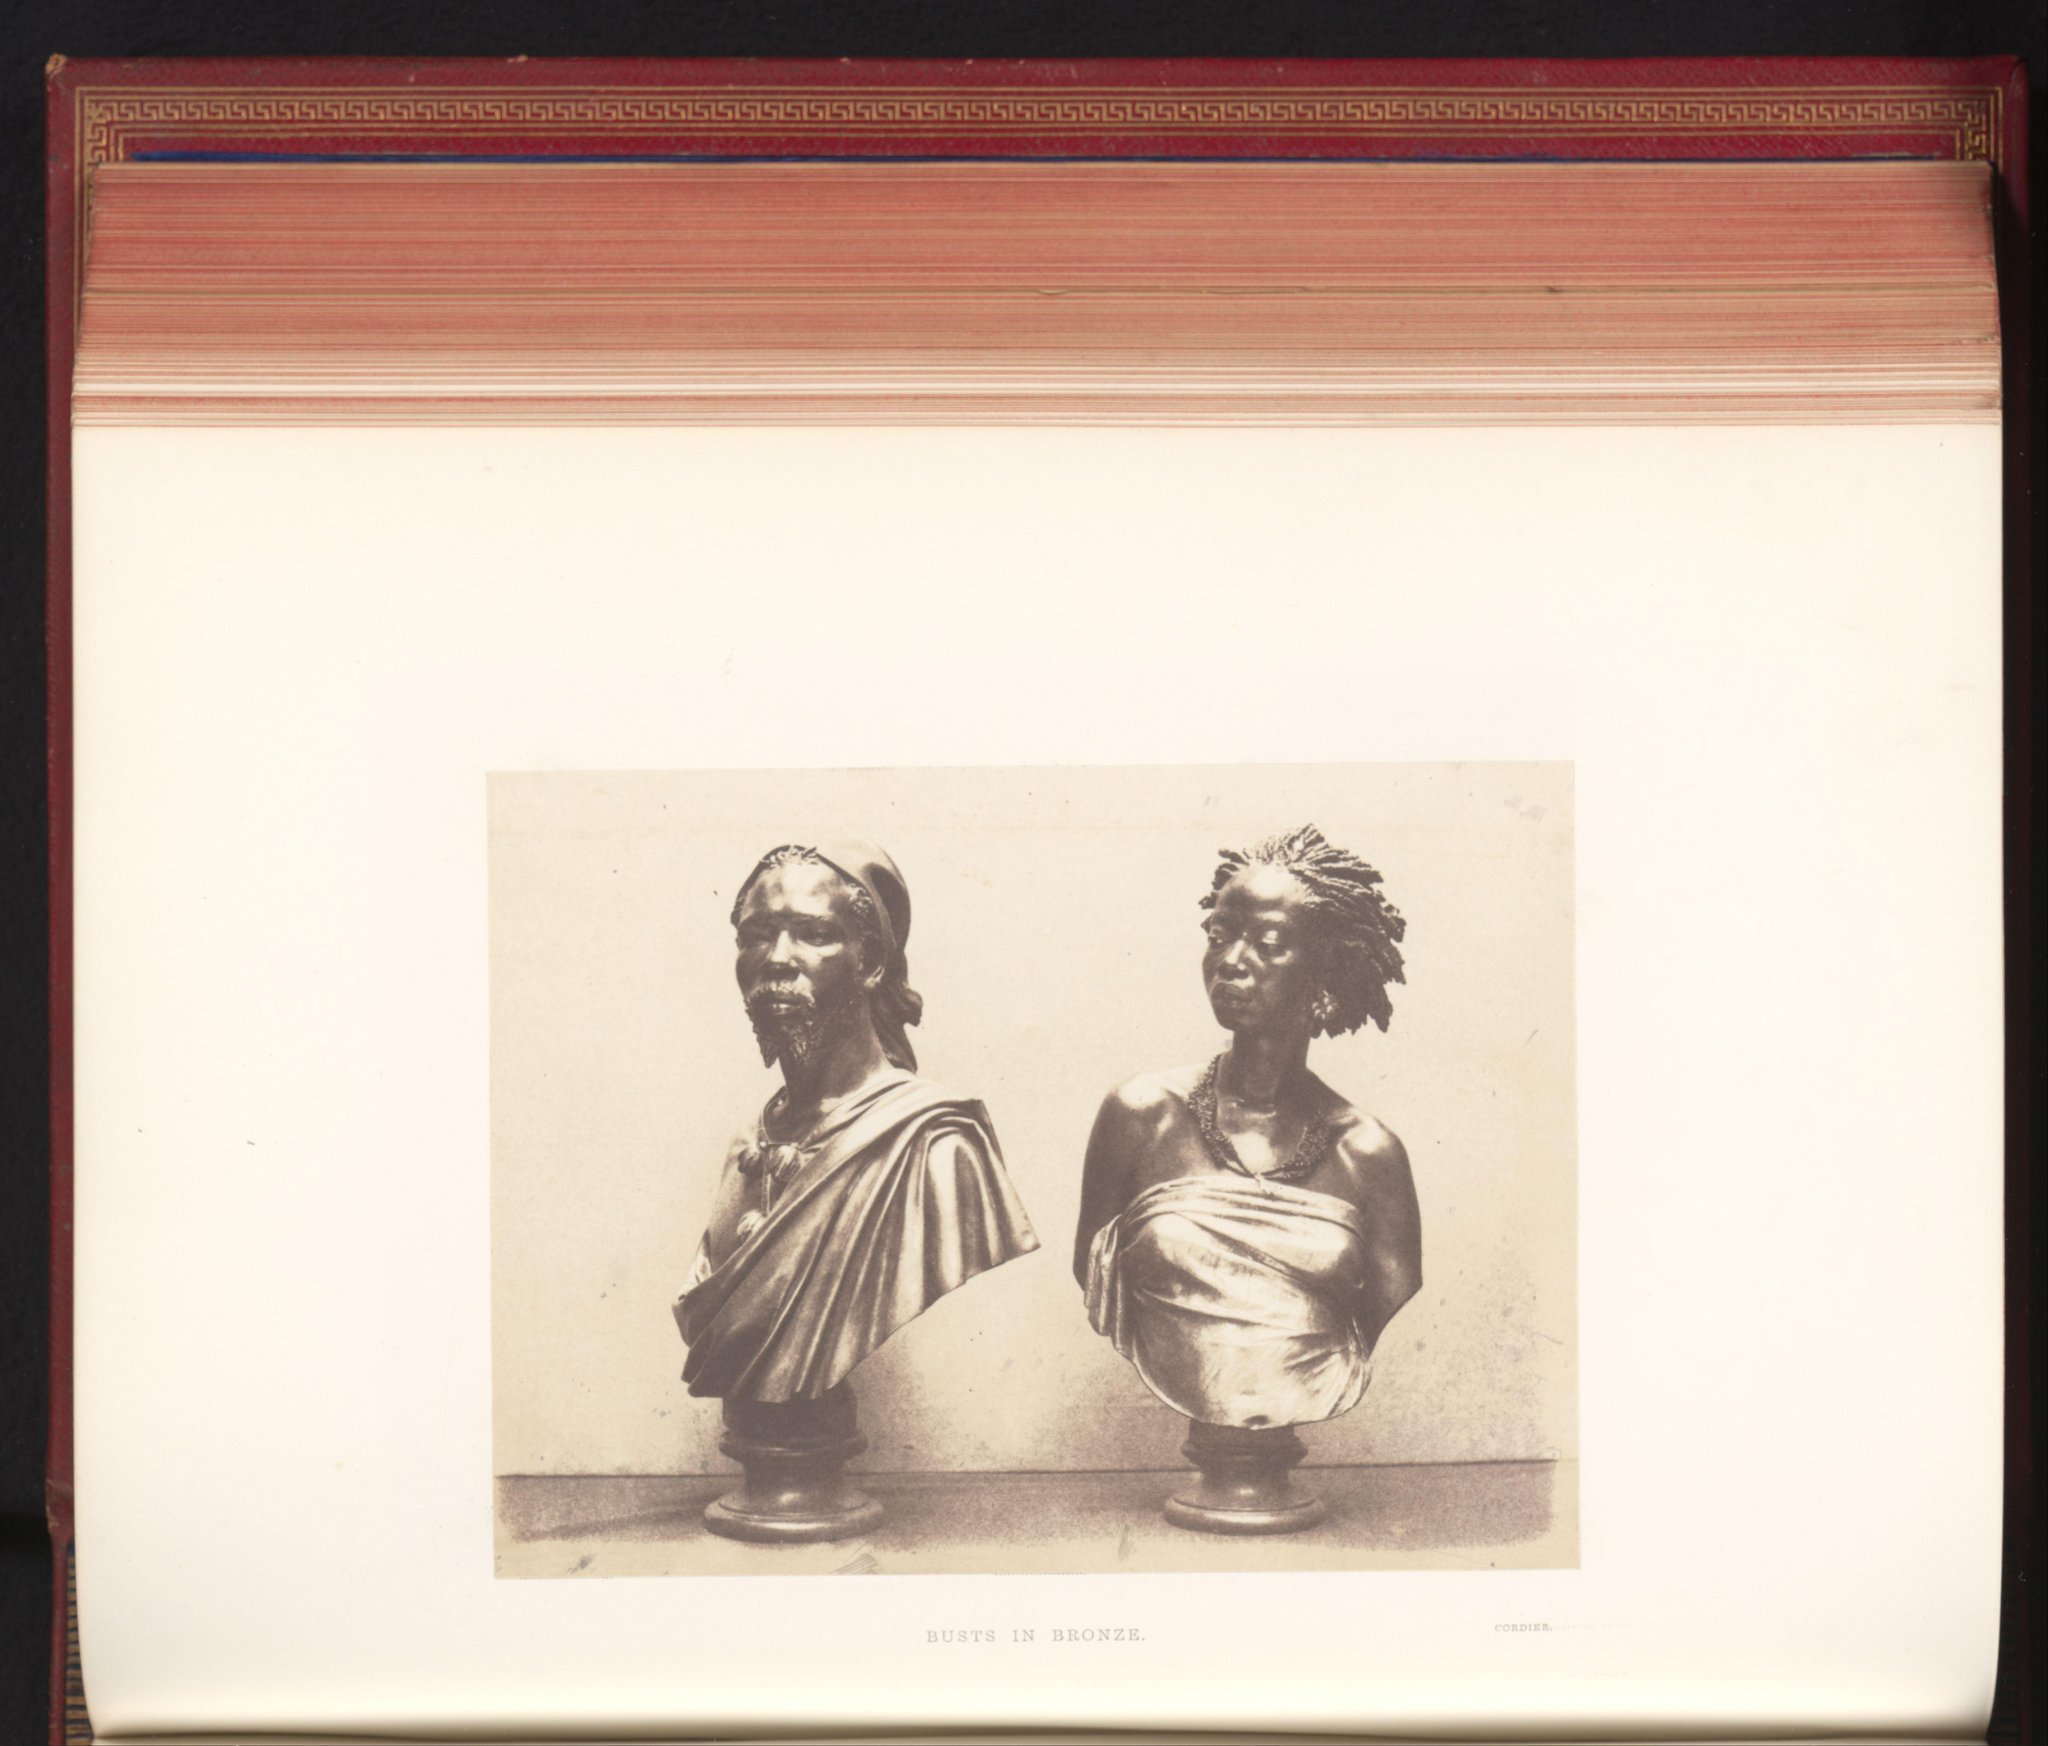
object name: photograph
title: Busts in Bronze. Cordier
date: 1851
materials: photographic support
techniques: salted paper print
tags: chest, bust, london